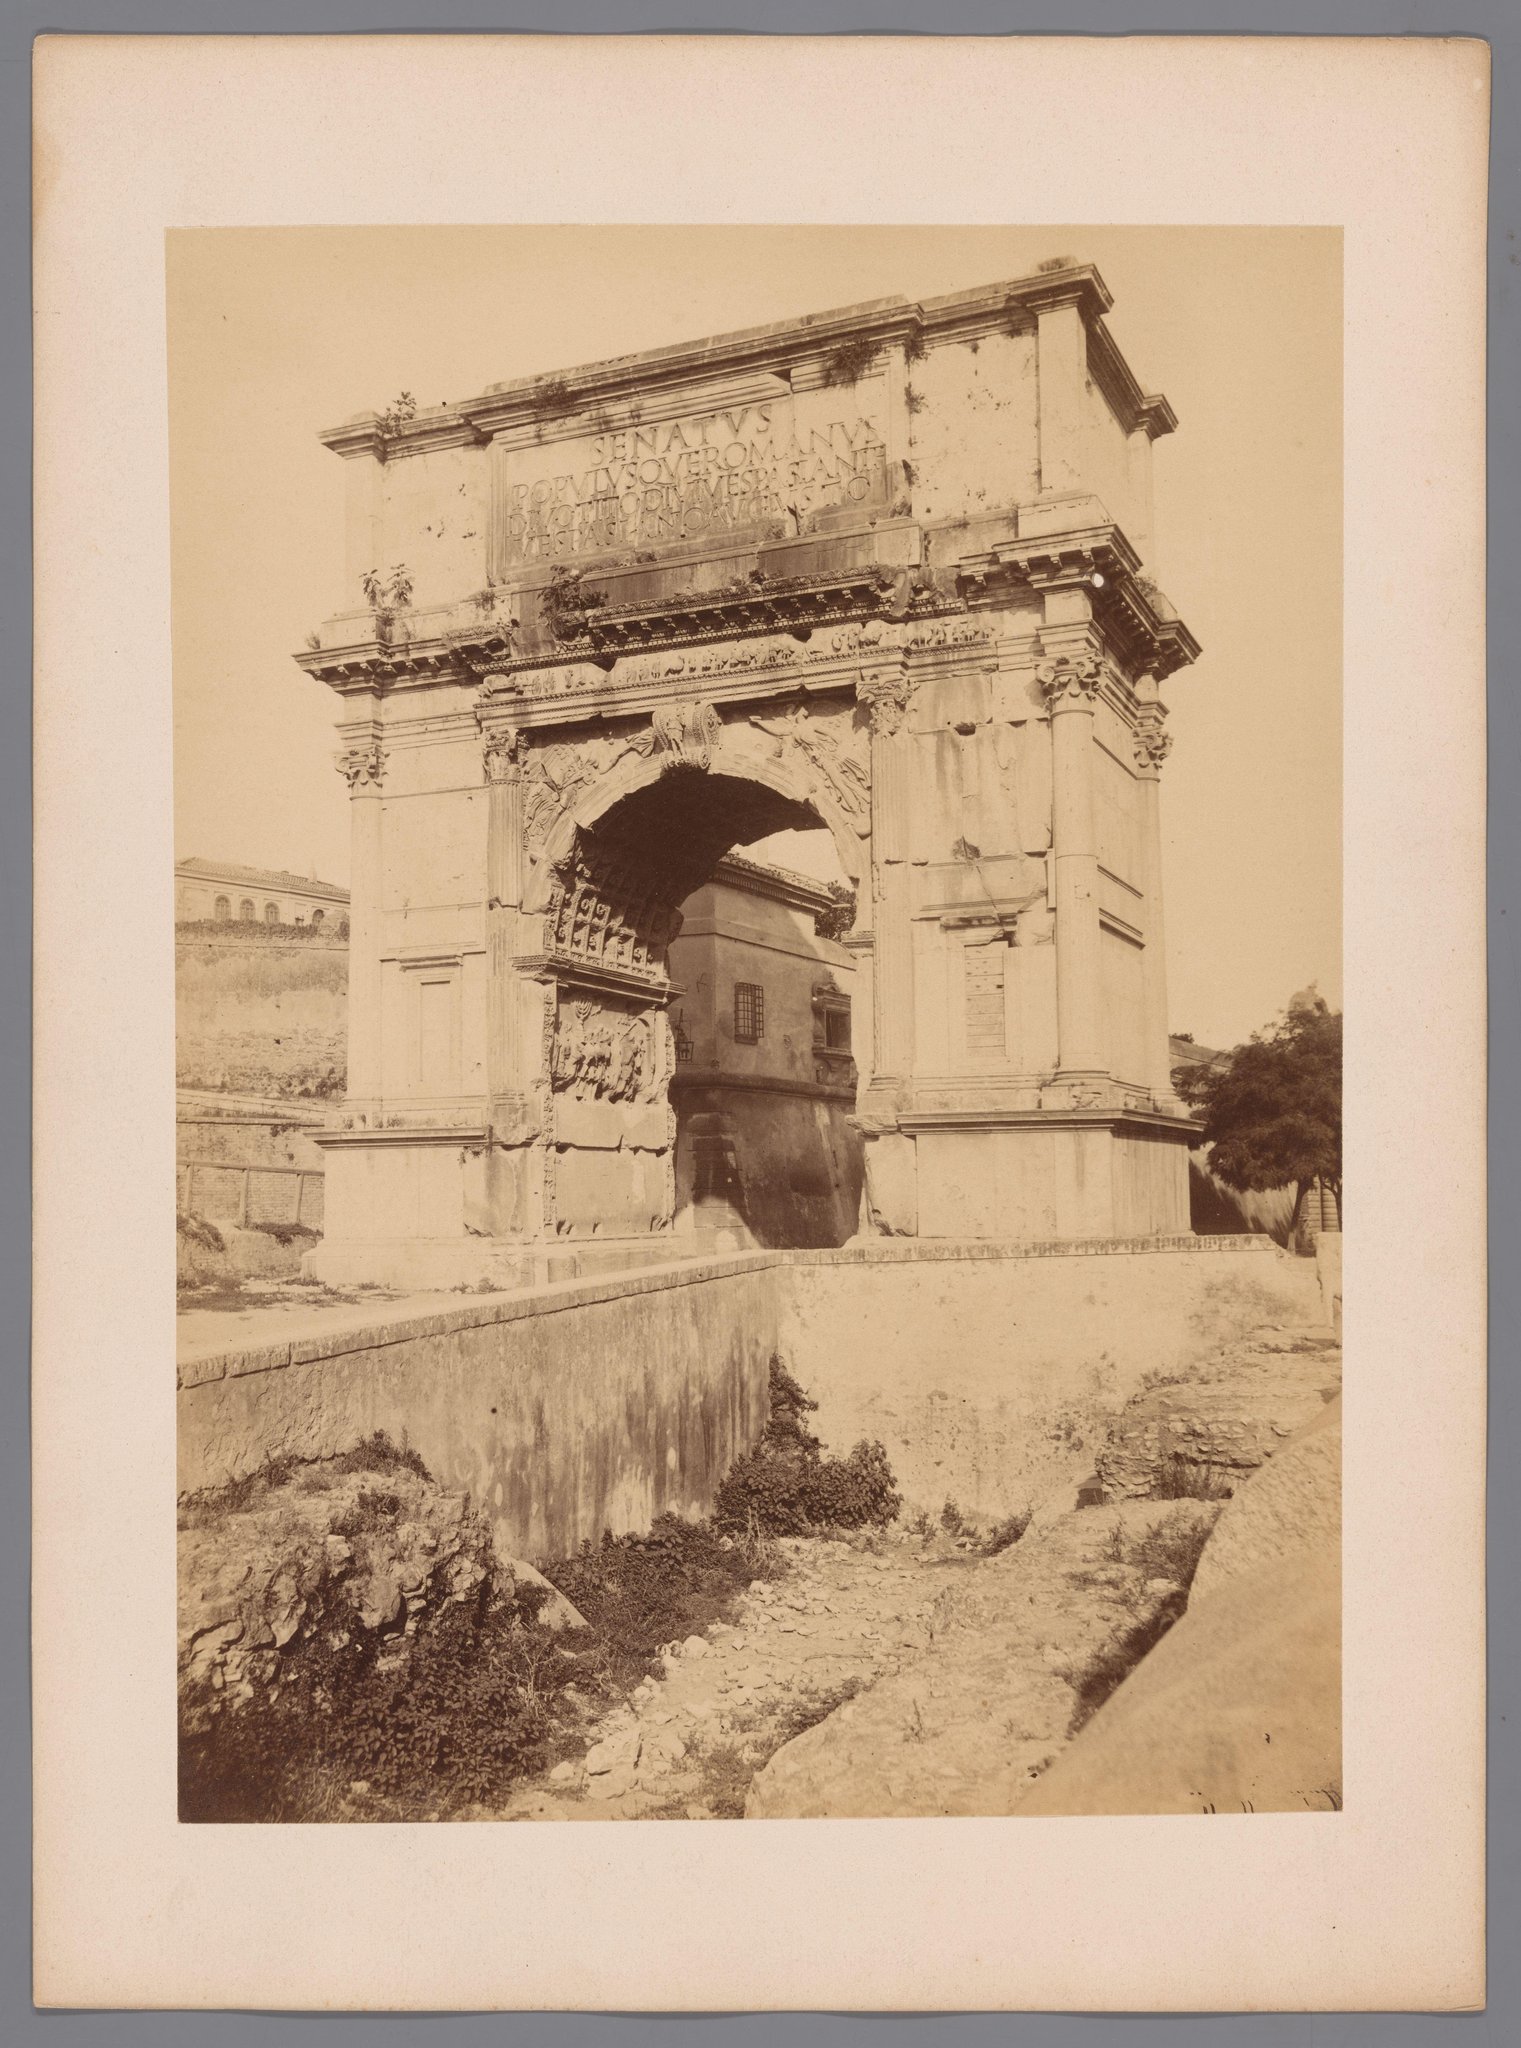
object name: photograph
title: Gezicht op de Boog van Titus te Rome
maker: Anonymous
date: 1851-1900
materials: cardboard, paper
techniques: albumen print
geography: rome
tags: triumphal arch